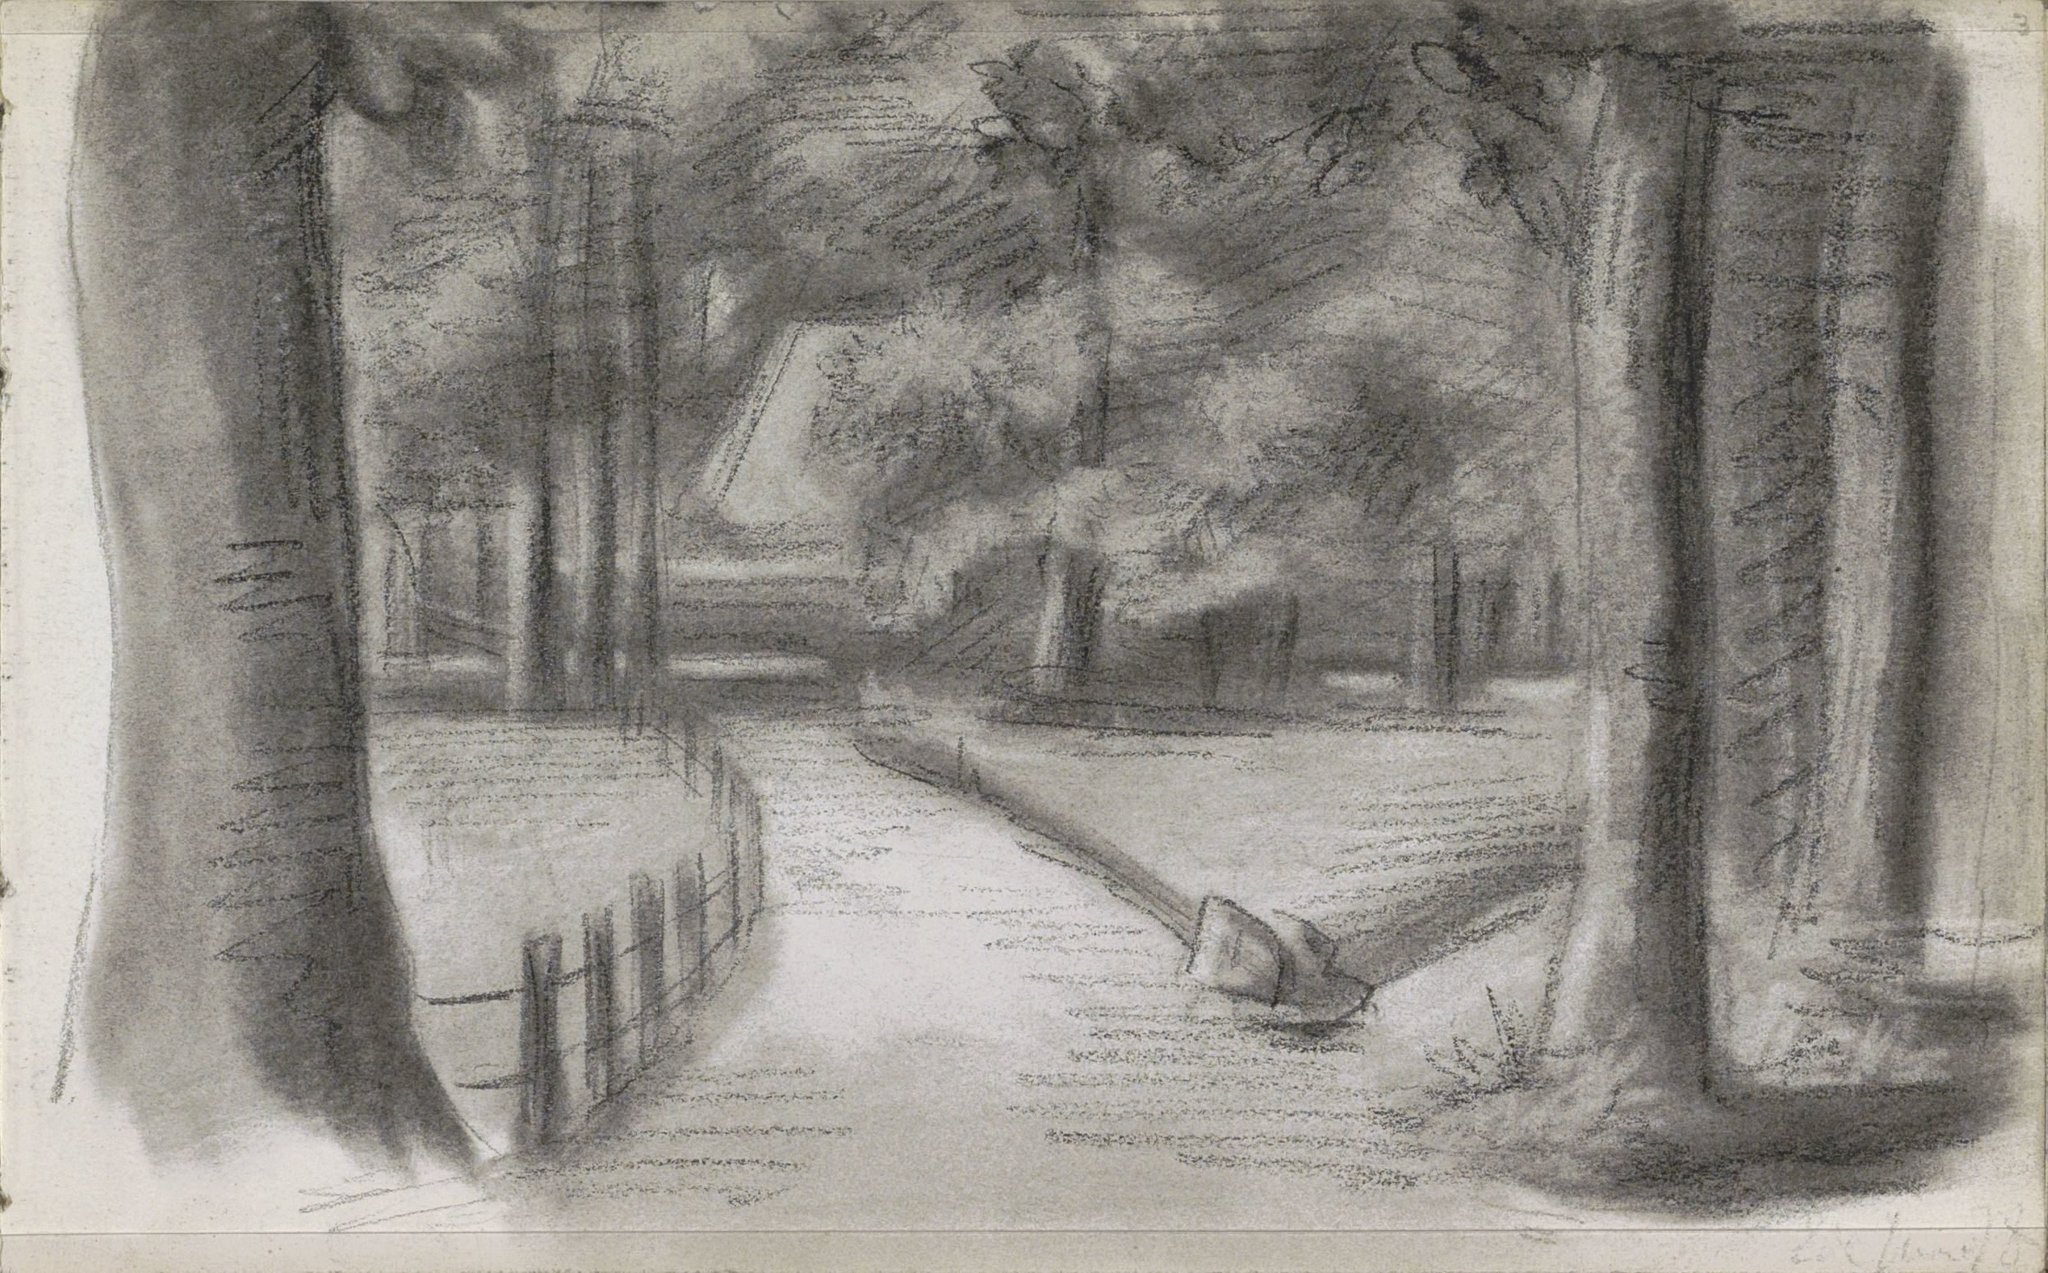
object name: sketchbook leaf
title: Gezicht op een bospad in Ede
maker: willem witsen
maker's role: draughtsman, painter, print maker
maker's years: 1860-1923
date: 1806-1878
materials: chalk, paper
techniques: stumping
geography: ede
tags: rural housing, e.g. country-house, villa, cottage, forest path or lane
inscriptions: annotation: ‘Ede’, date: ‘Juni 78’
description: Tweesprong met in de verte bebouwing. Pagina 3 uit een schetsboek met 23 bladen.